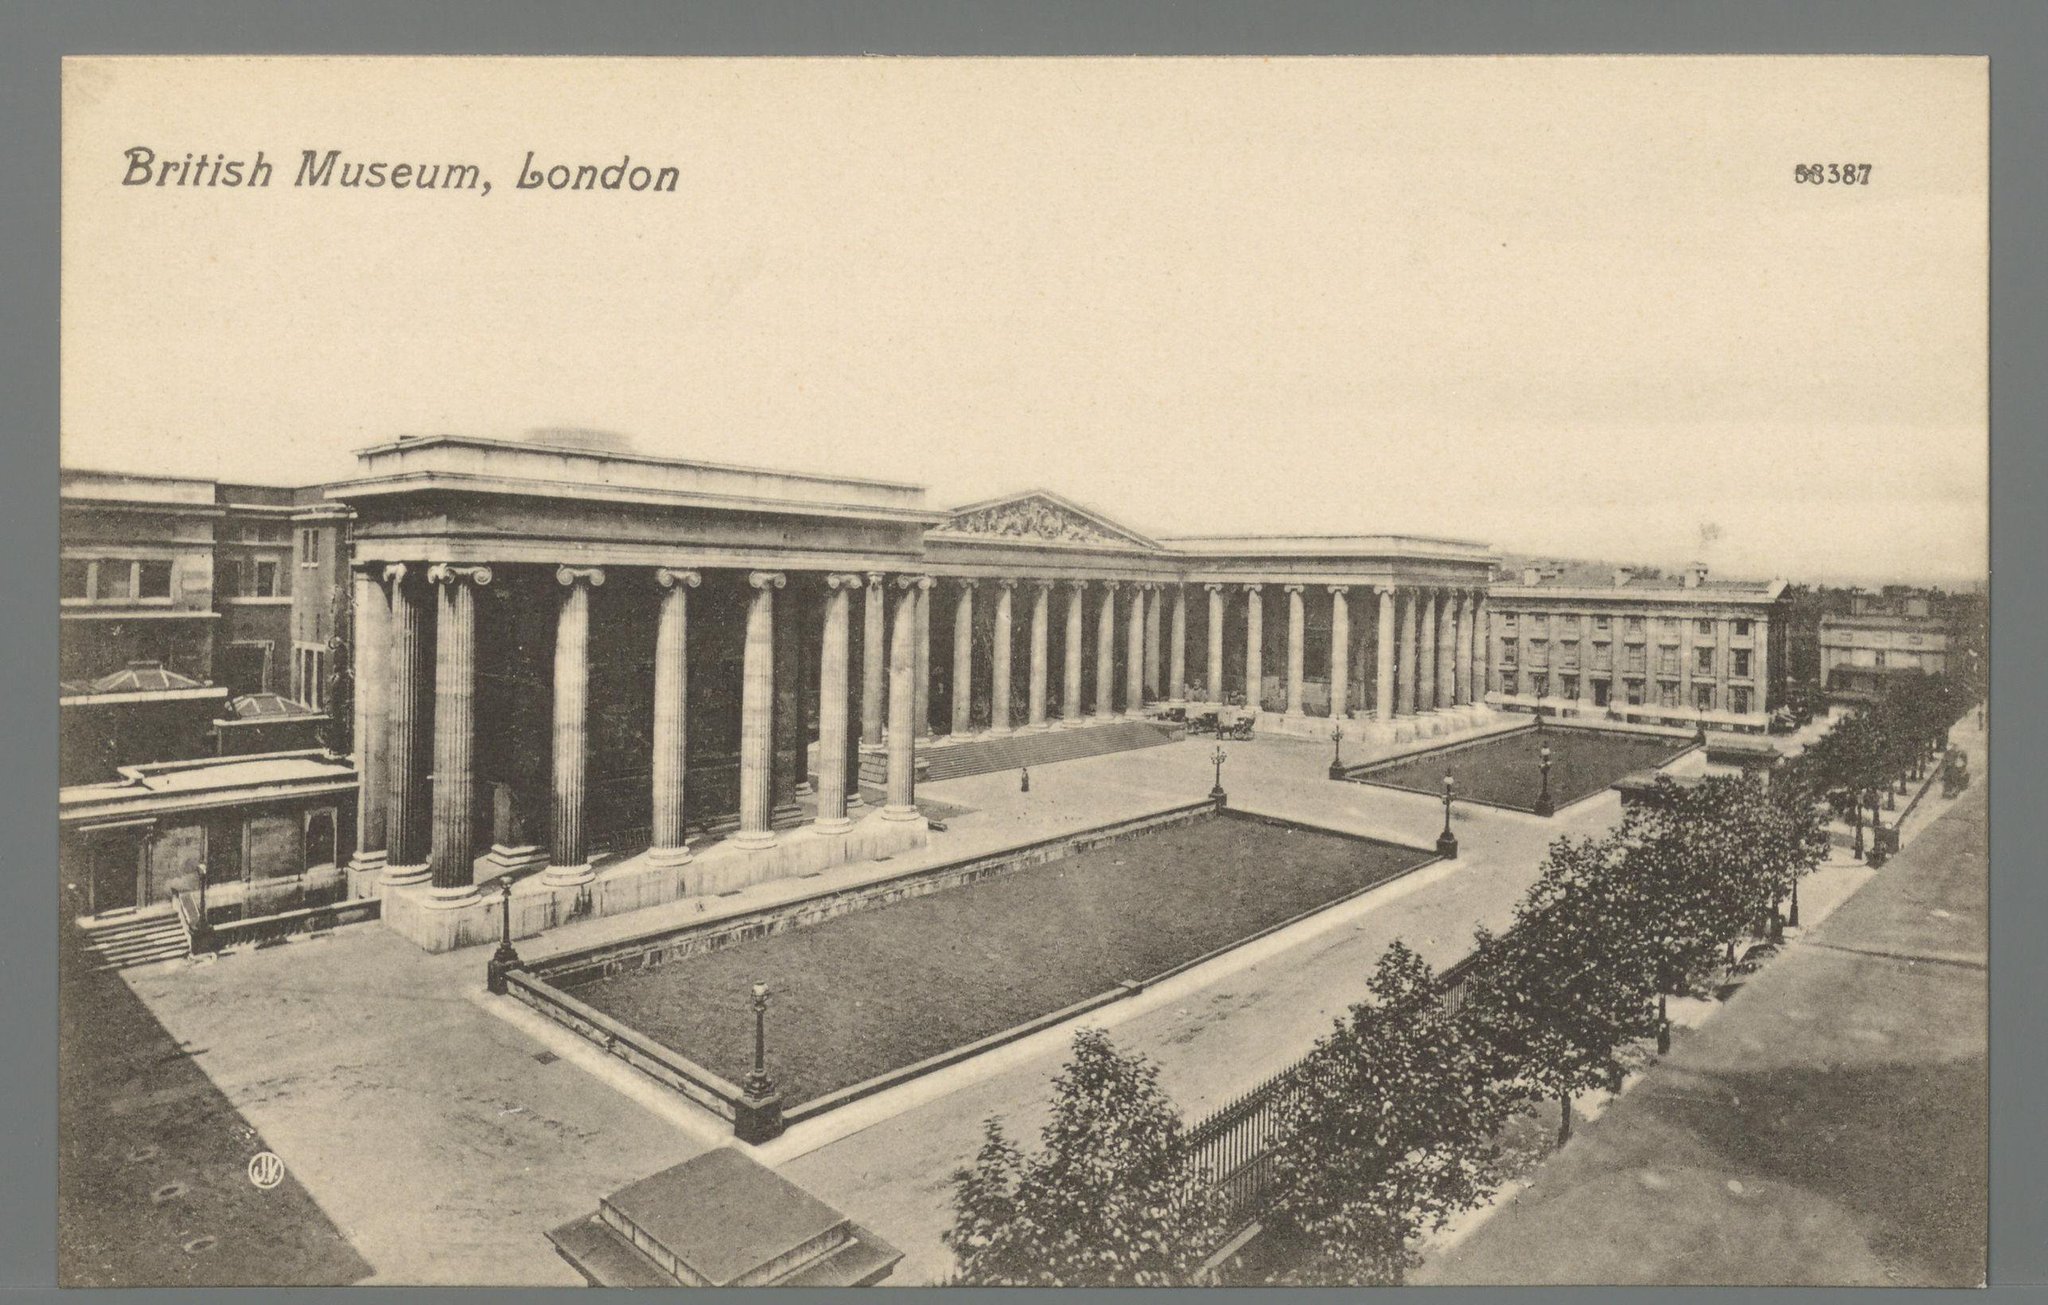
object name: ansichtkaart, prentbriefkaart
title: British Museum, London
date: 1902-1930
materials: cardboard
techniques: photograph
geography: great britain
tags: permanent exhibition, museum